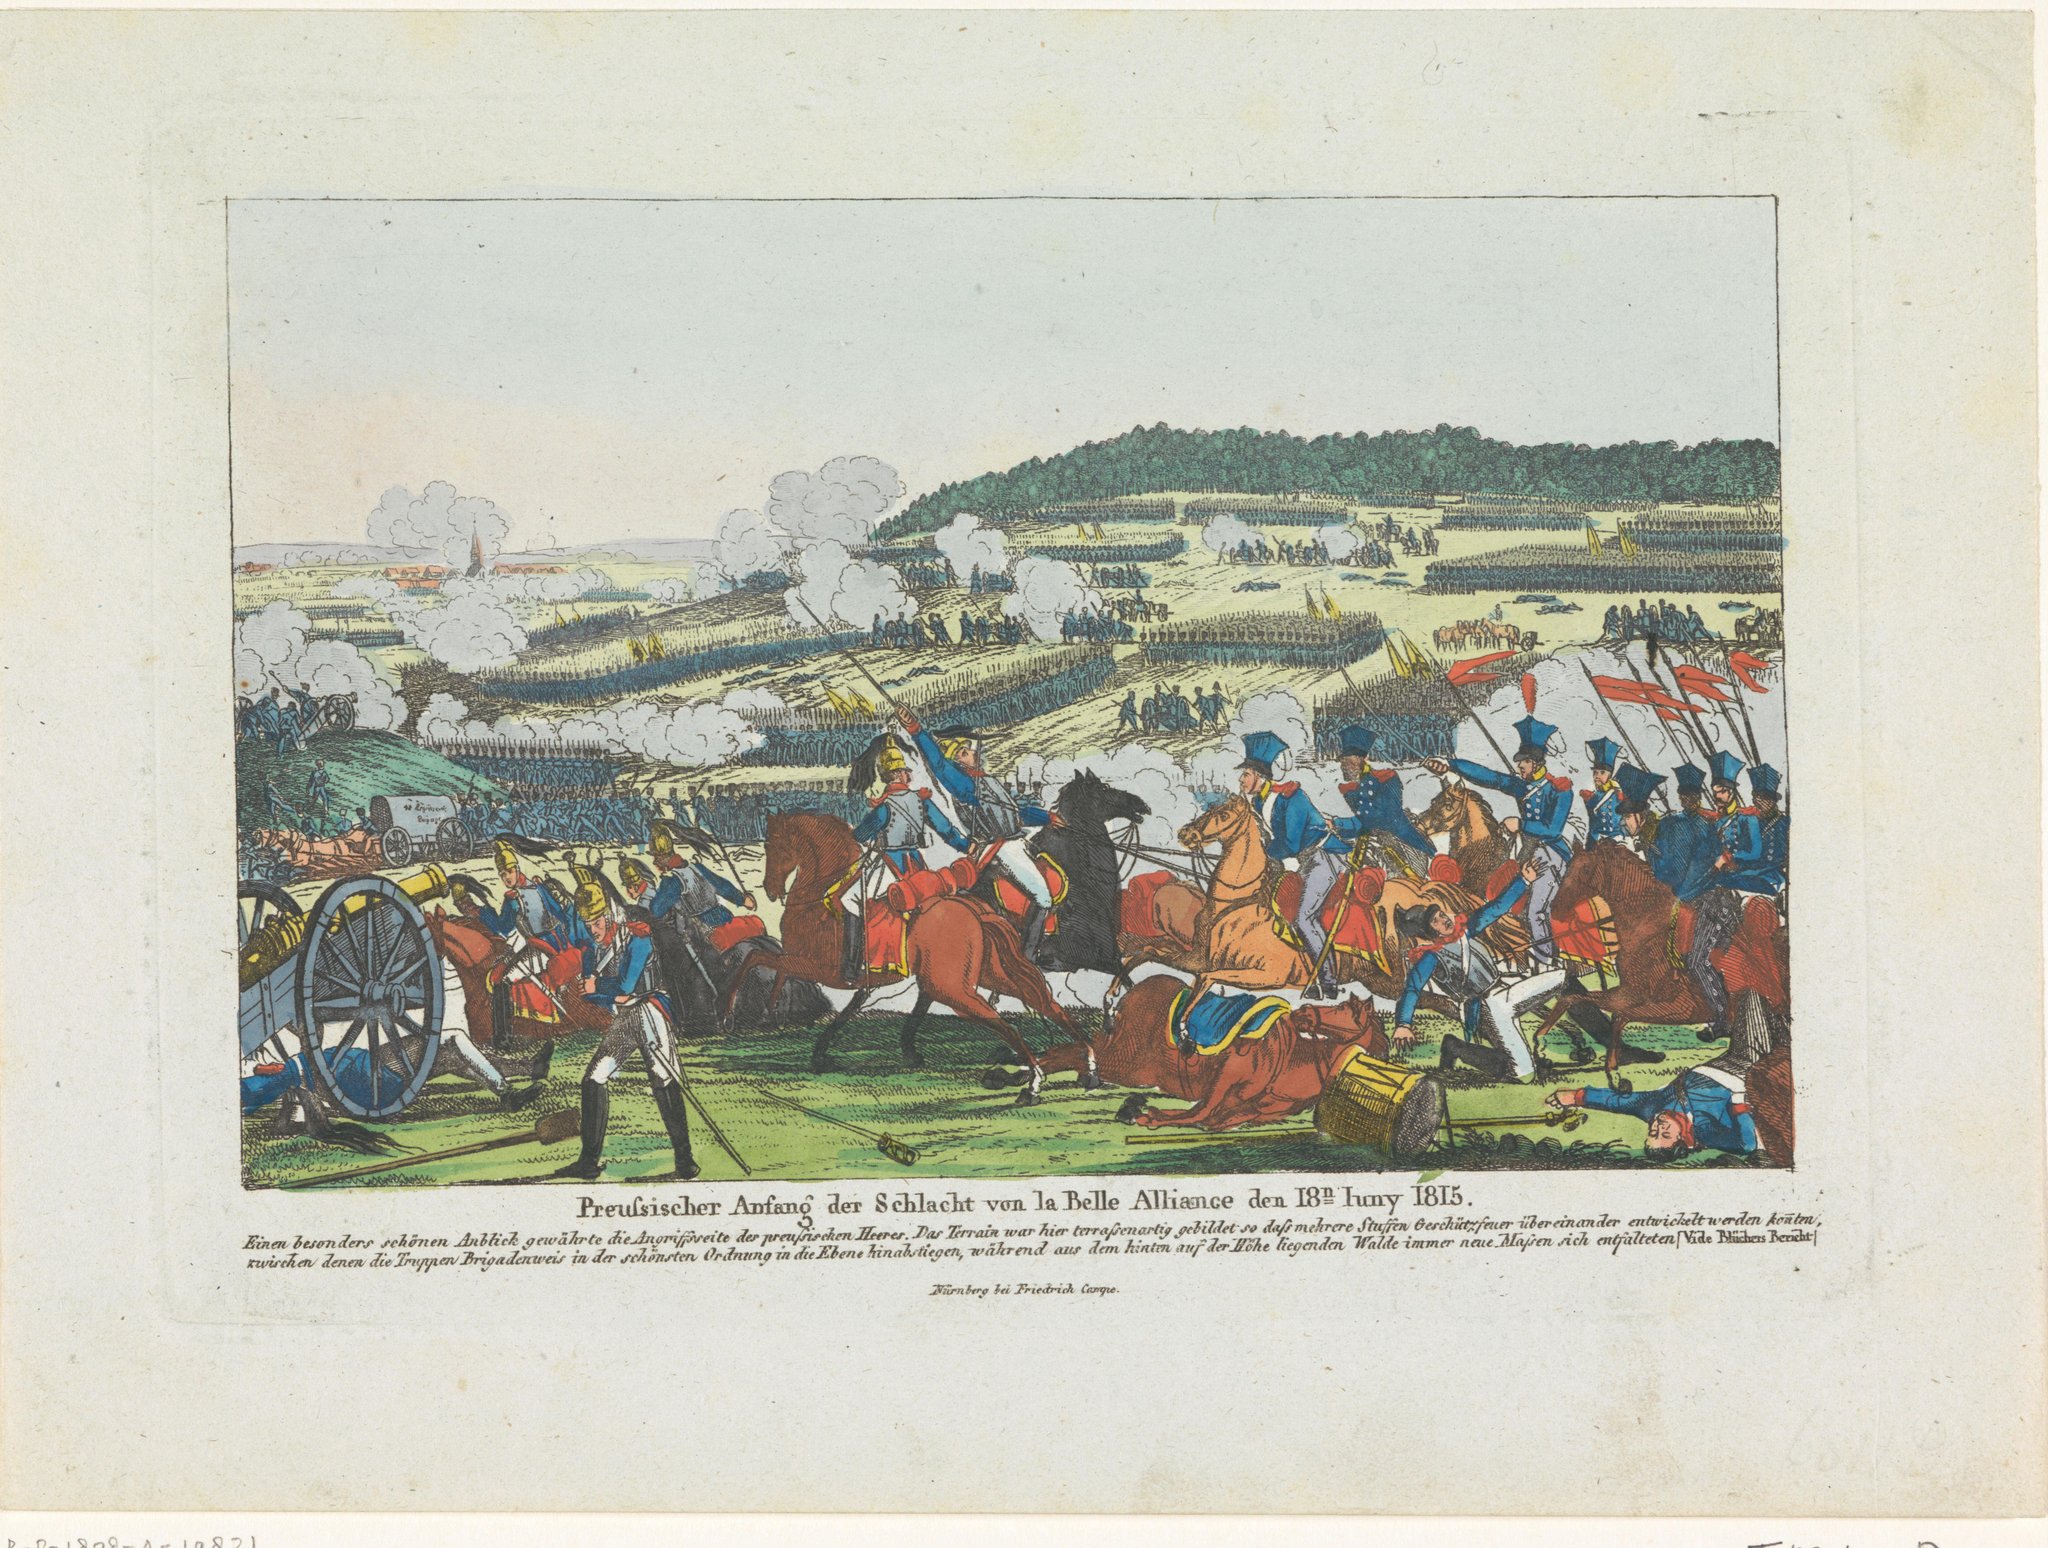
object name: print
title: Preussischer Anfang der Schlacht von la Belle Alliance den 18n Iuny 1815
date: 1815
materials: paper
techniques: etching, hand coloring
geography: nuremberg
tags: battle (+ land forces), waterloo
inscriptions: collector's mark: Lugt 2228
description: Oprukken in formatie van de Pruisische troepen in de slag bij La Belle Alliance, beter bekend als de Slag bij Waterloo, 18 juni 1815. Met tweeregelig onderschrift in het Duits.